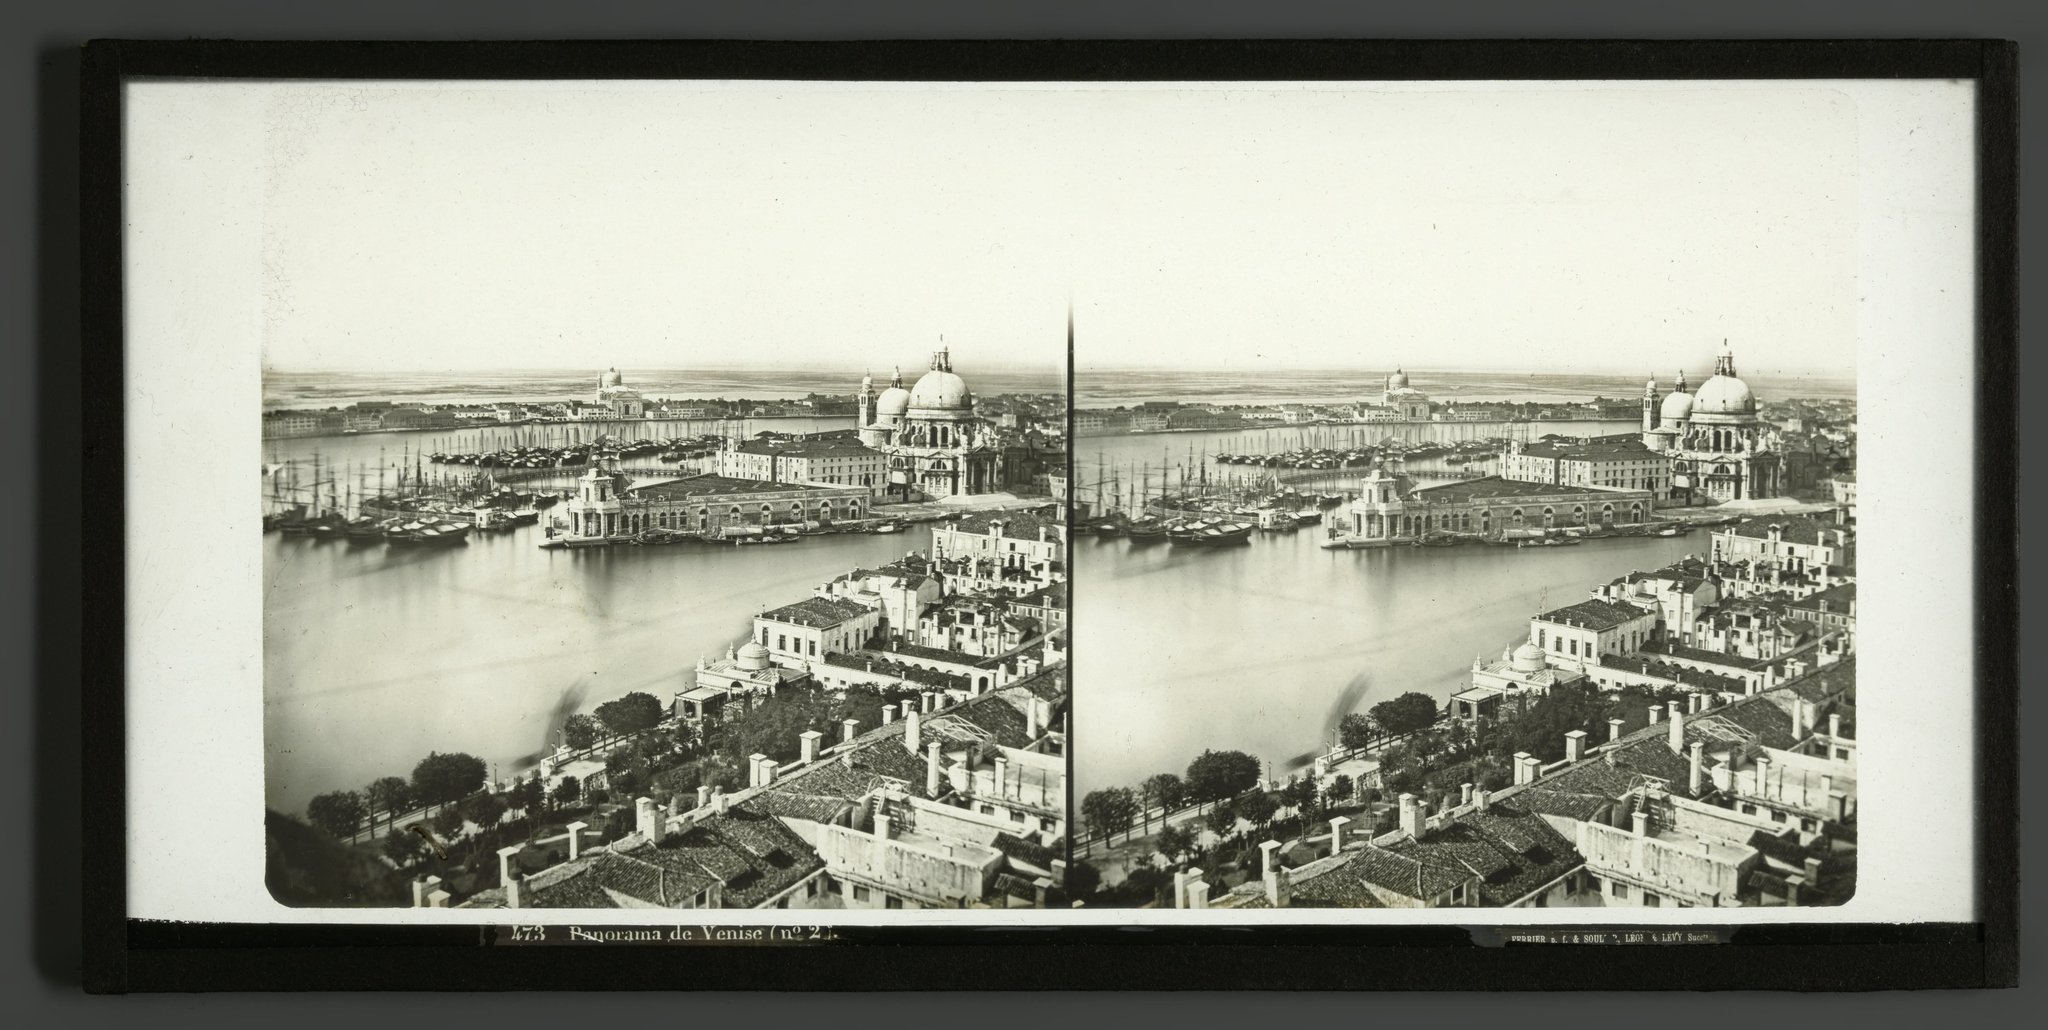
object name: stereoscopic photograph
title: Gezicht op Venetië, Italië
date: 1860-1870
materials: glass, paper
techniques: slide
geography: venice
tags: prospect of city, town panorama, silhouette of city, venice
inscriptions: inscription: ‘473. Panorama de Venise (no. 2).’